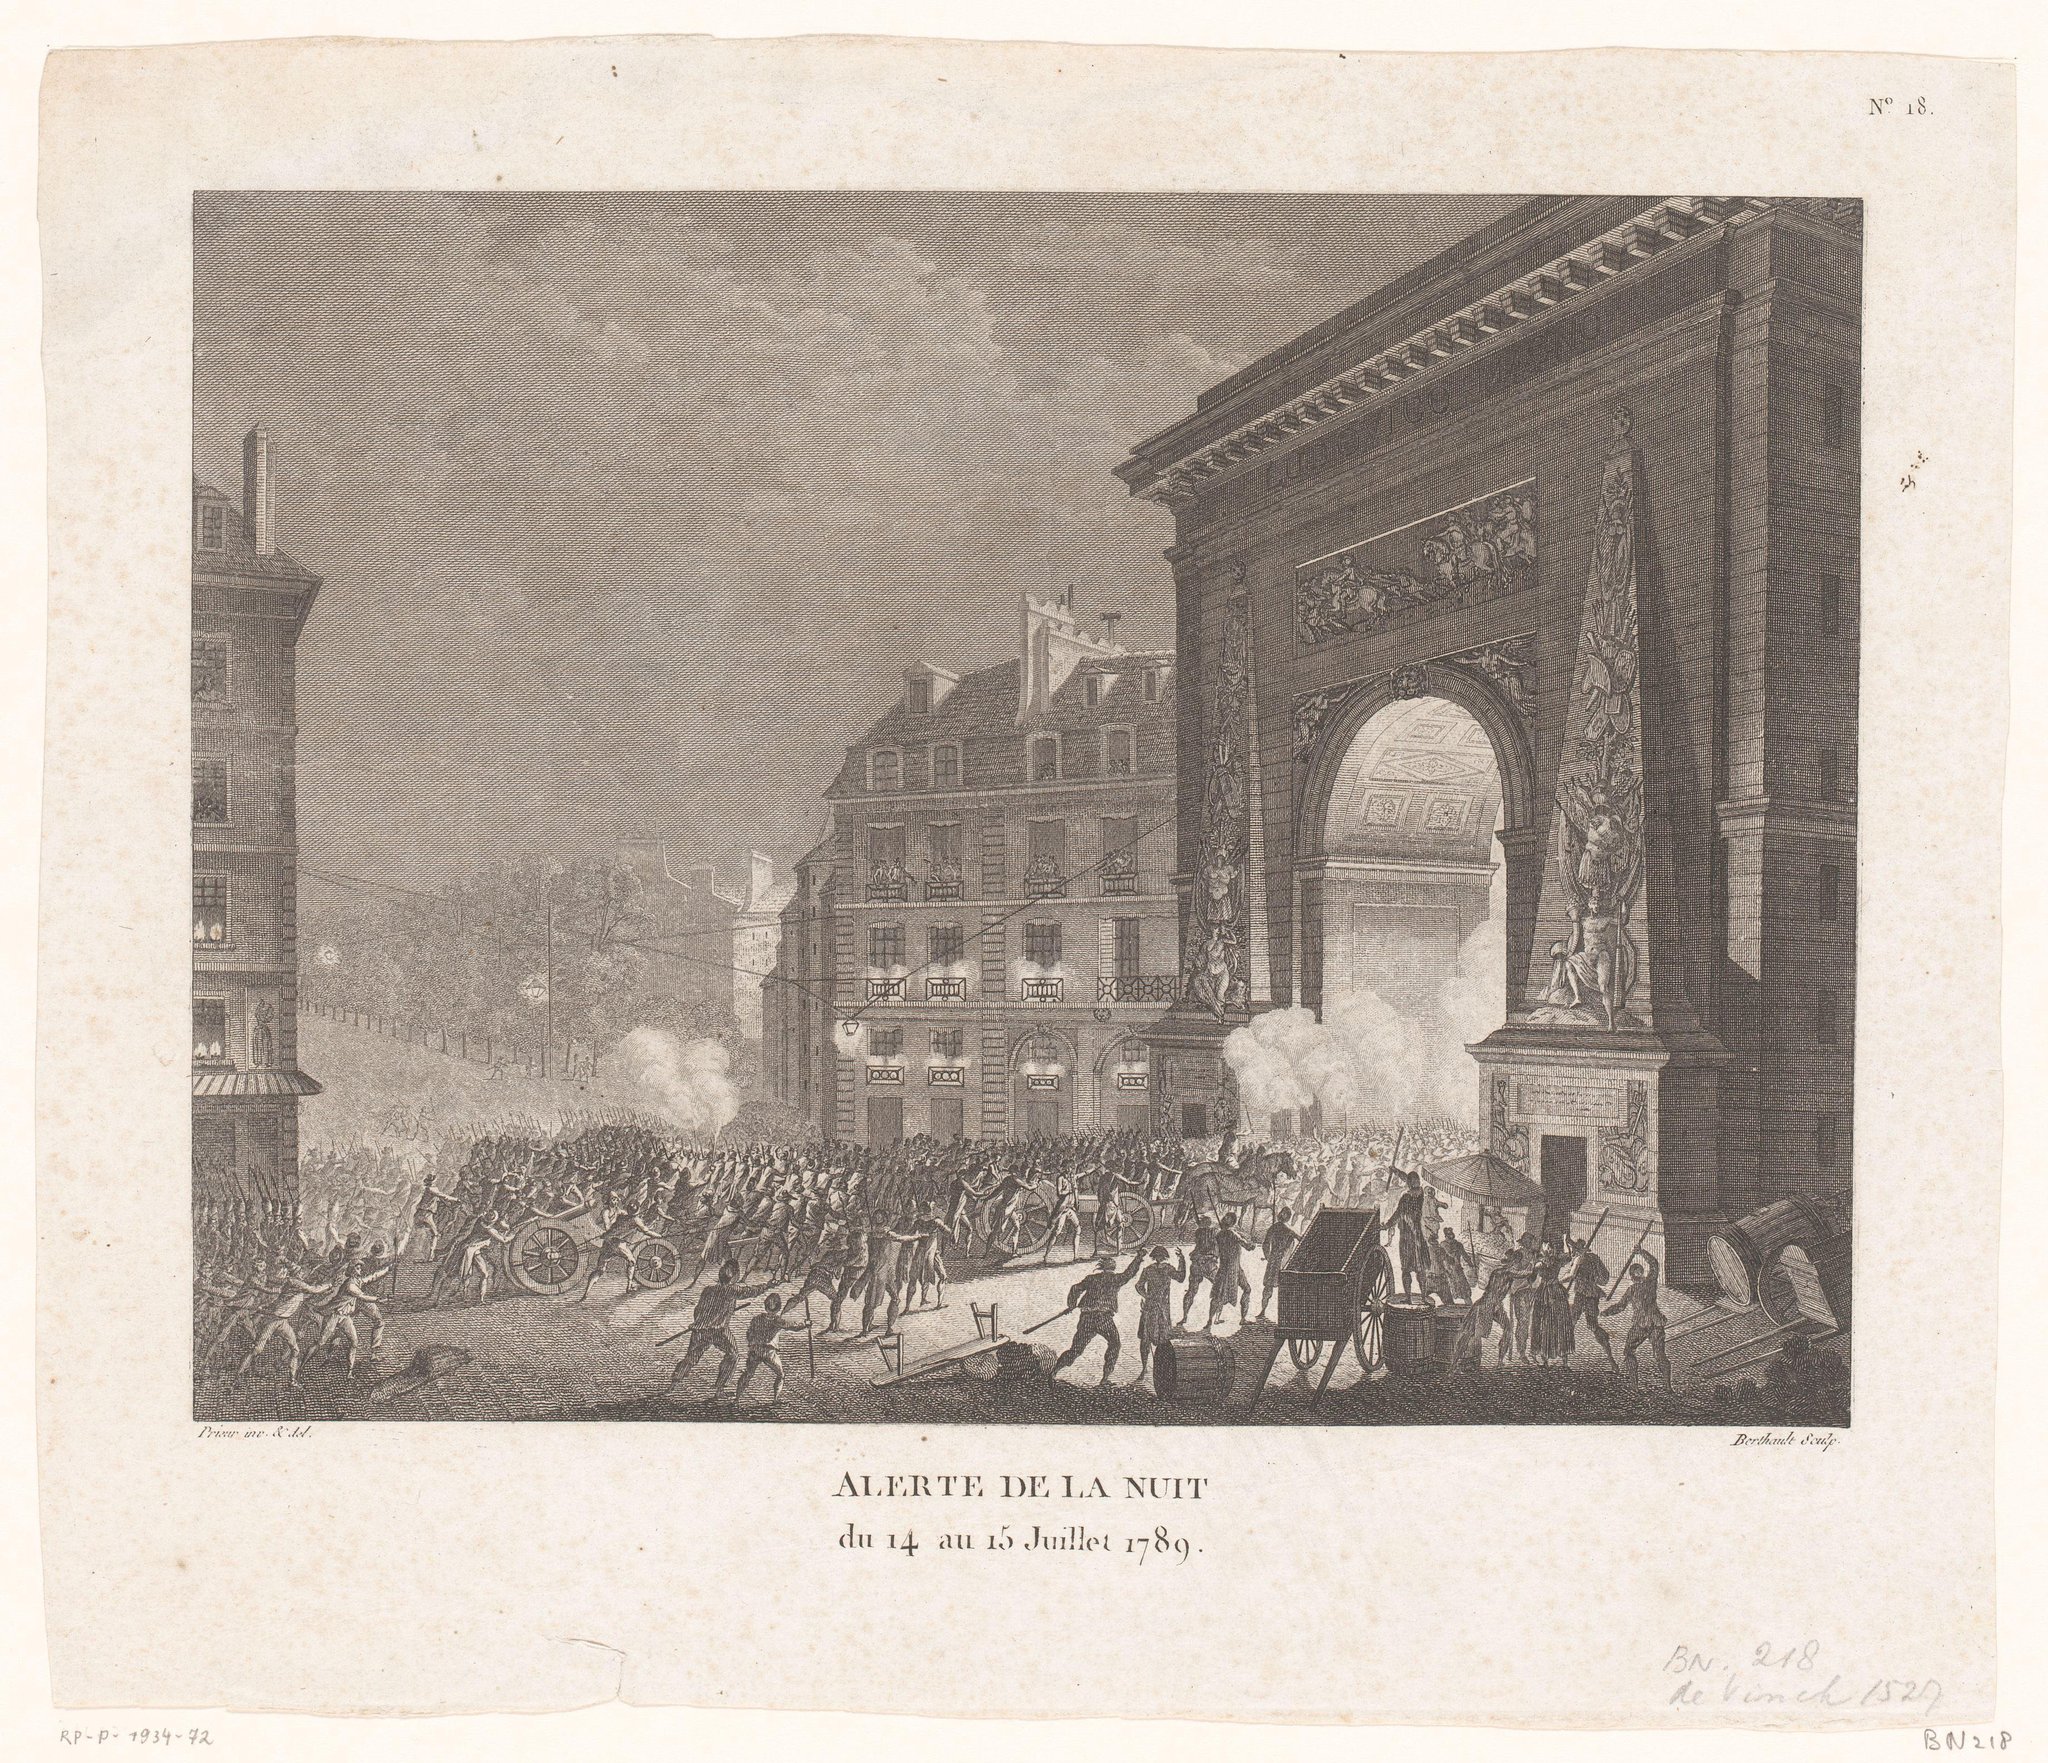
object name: print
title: Alerte de la nuit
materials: paper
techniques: etching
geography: france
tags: battle, fighting in general, night, paris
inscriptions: collector's mark: Lugt 2228